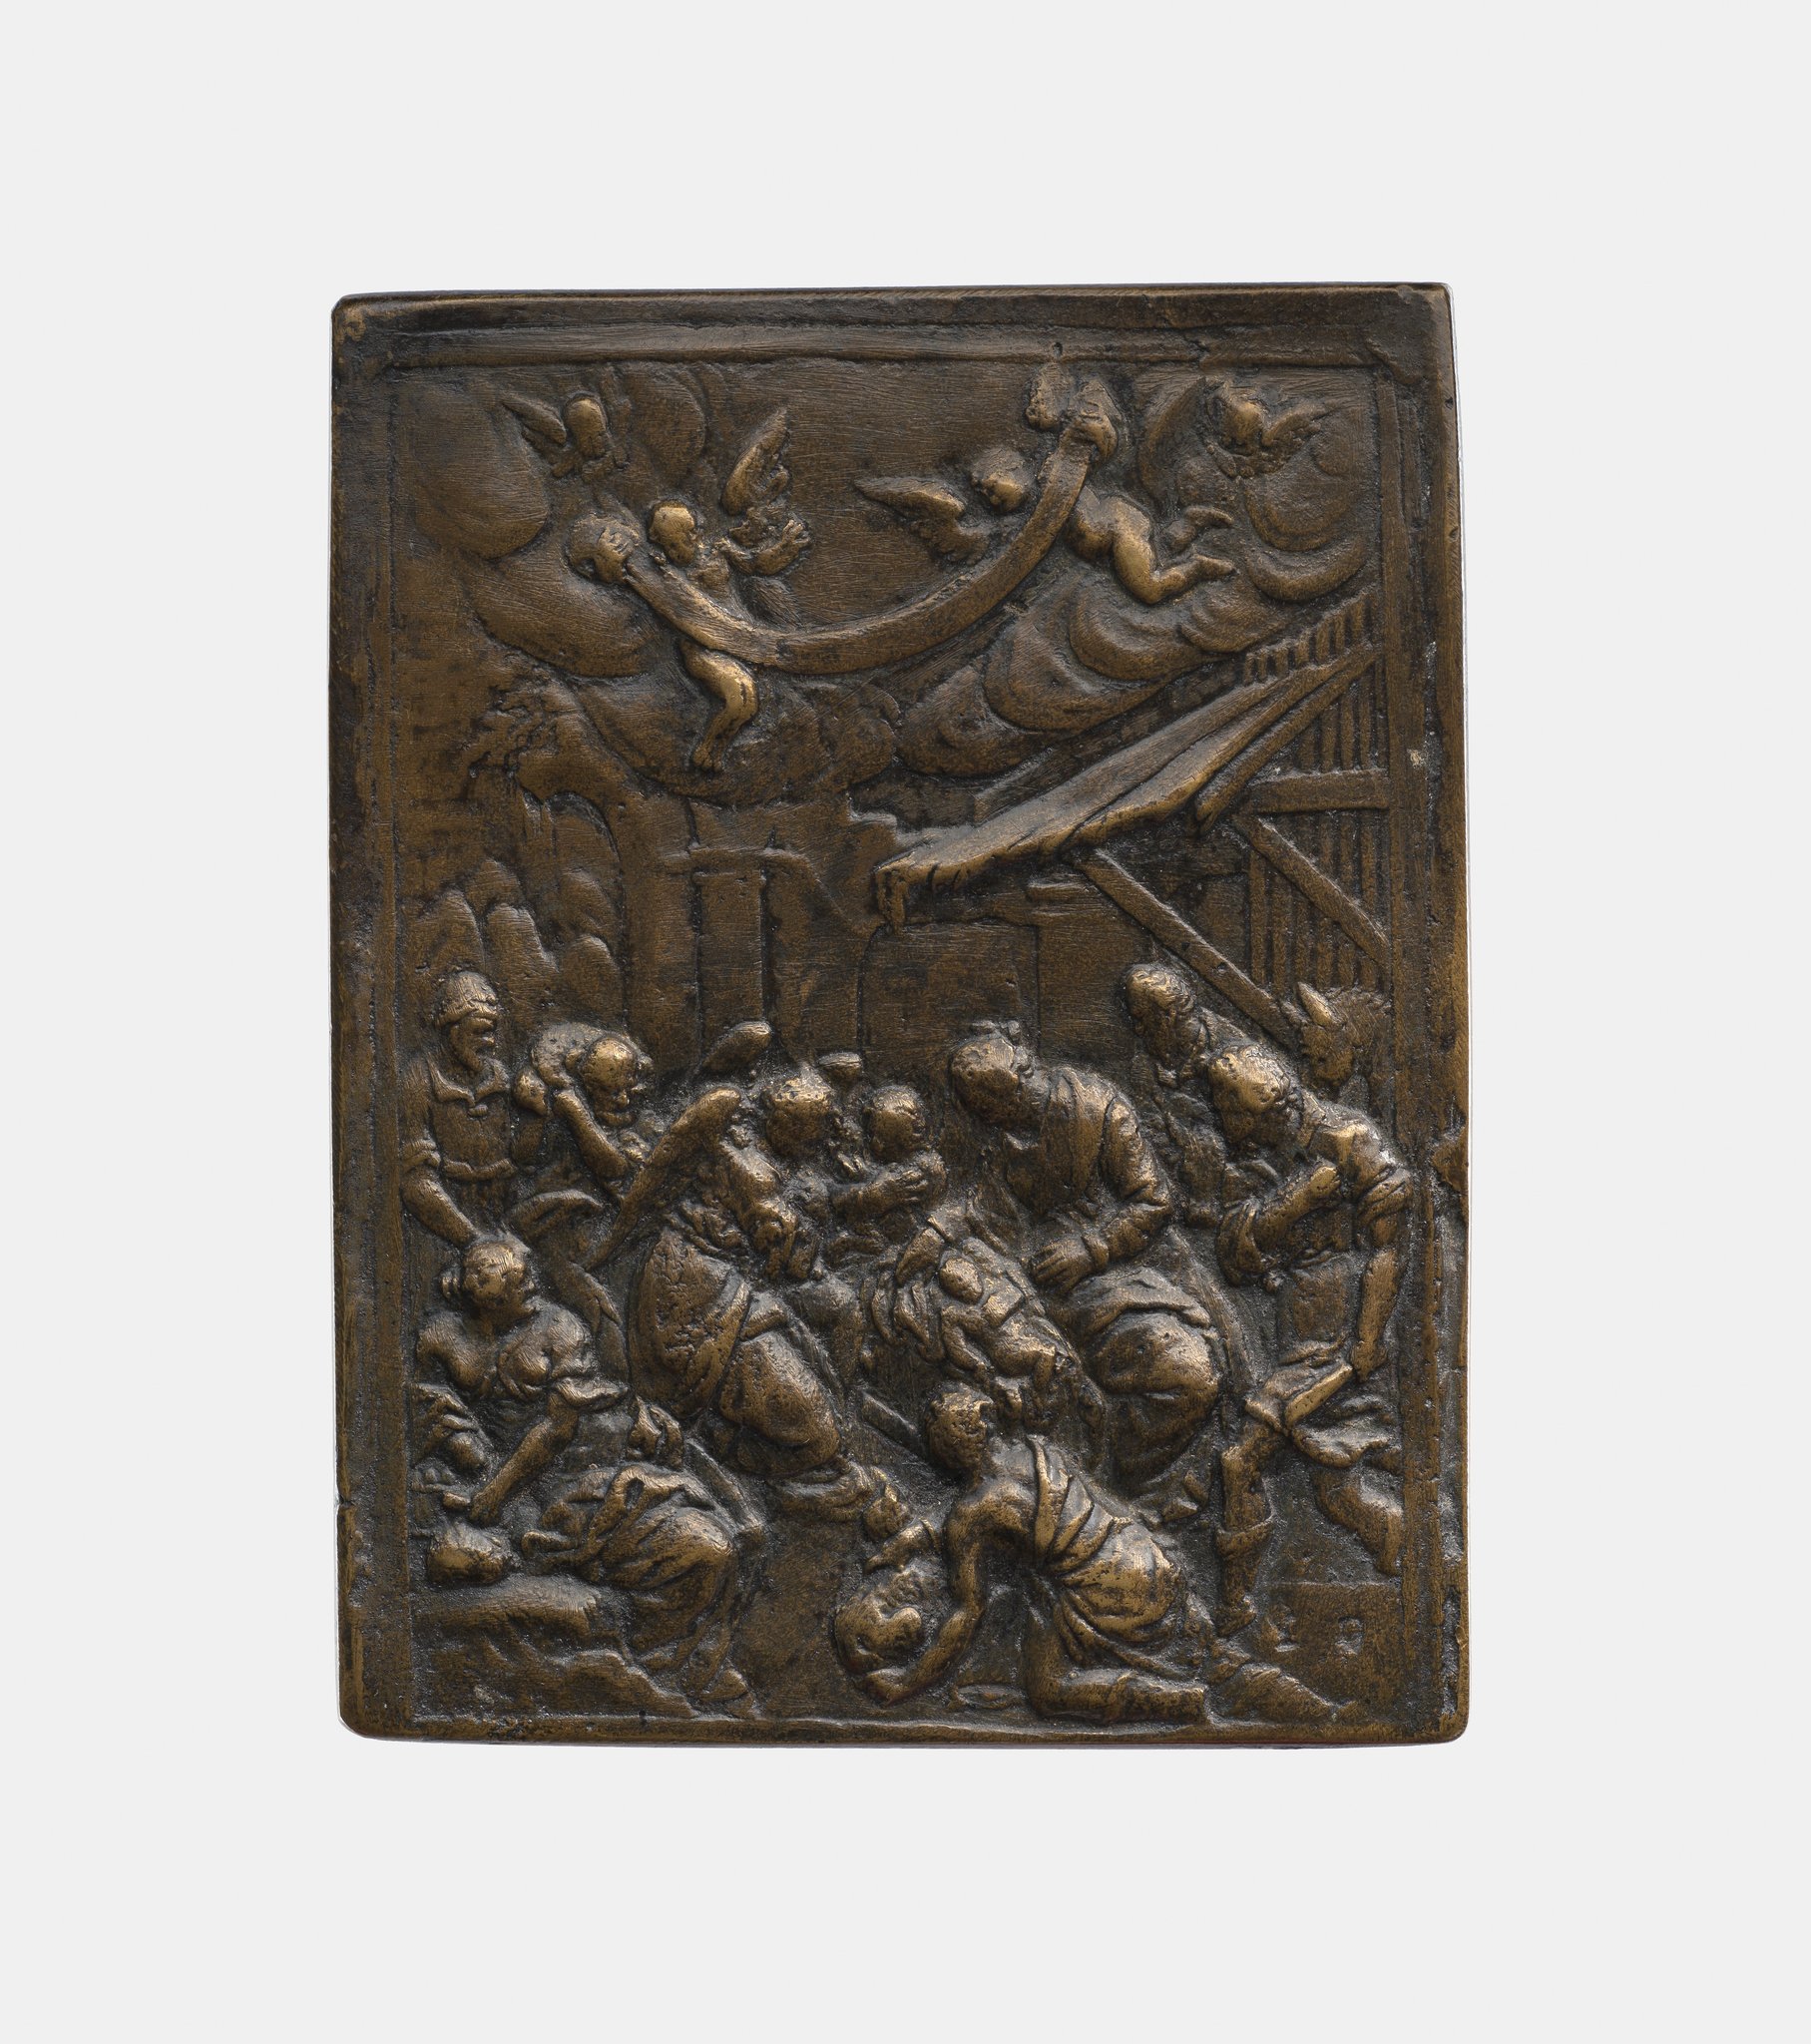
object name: plaquette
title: Adoration of the Shepherds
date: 1600-1650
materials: bronze